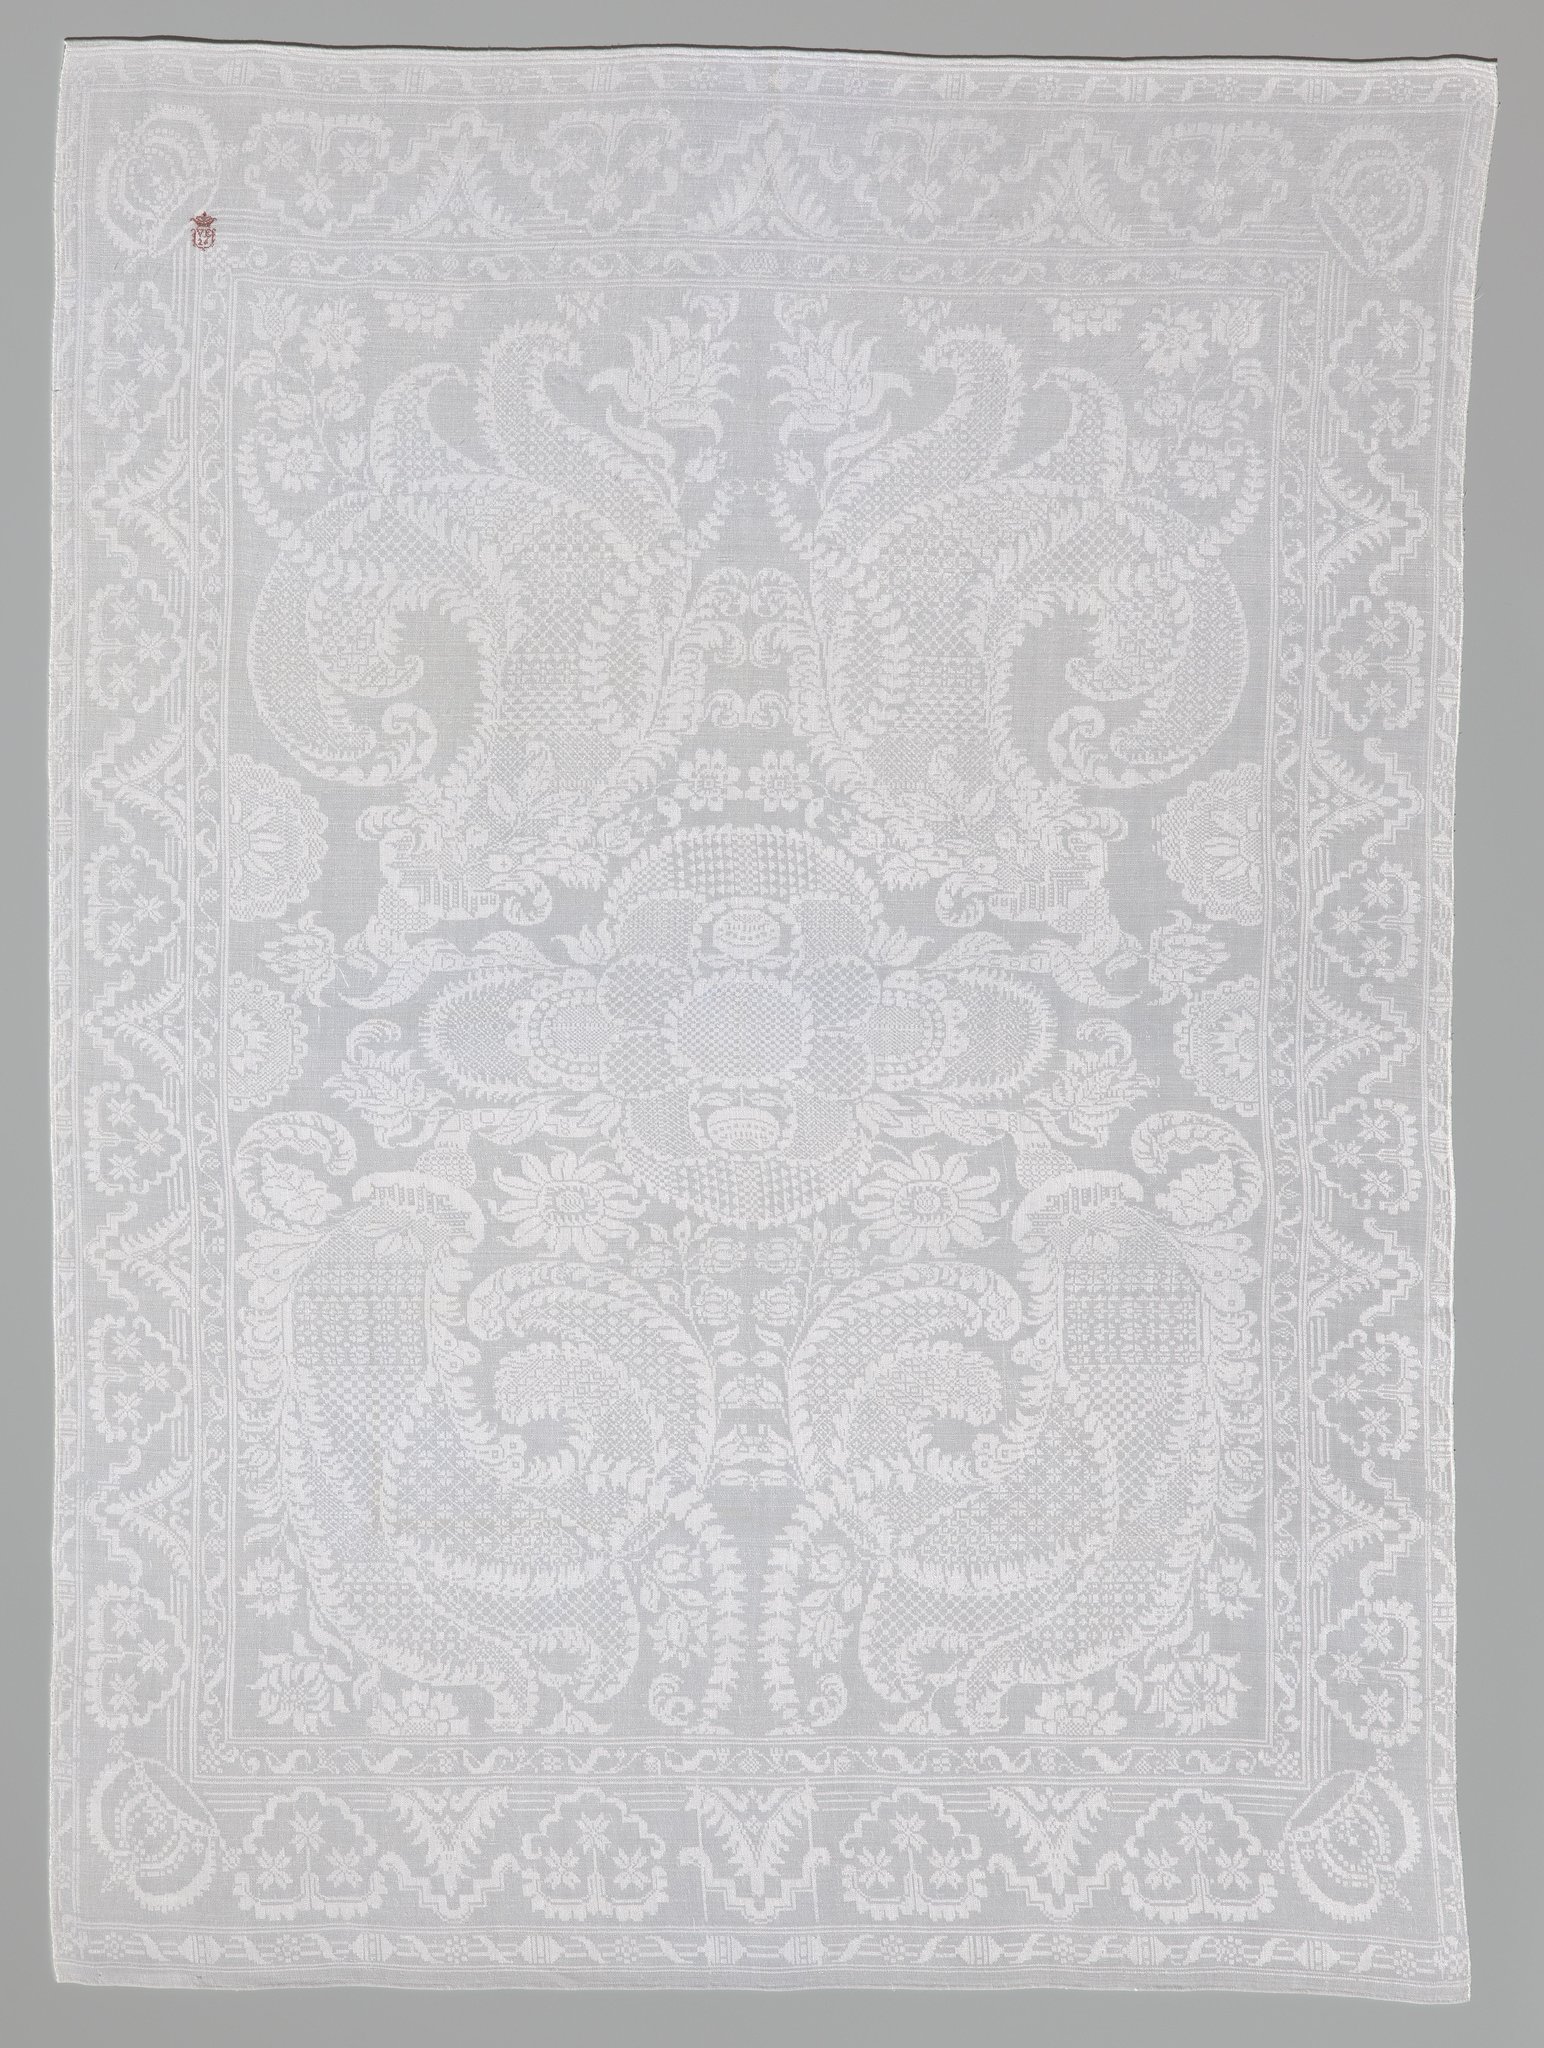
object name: napkin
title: Servet van linnendamast met een kantpatroon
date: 1725-1735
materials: linen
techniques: damask, weave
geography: flanders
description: Servet van linnendamast met een kantpatroon. Bij het servet hoort een servet met invnr. BK-1980-104-A en een tafellaken (BK-1980-103). Het servet is gemerkt: gekroonde letters VE 26.